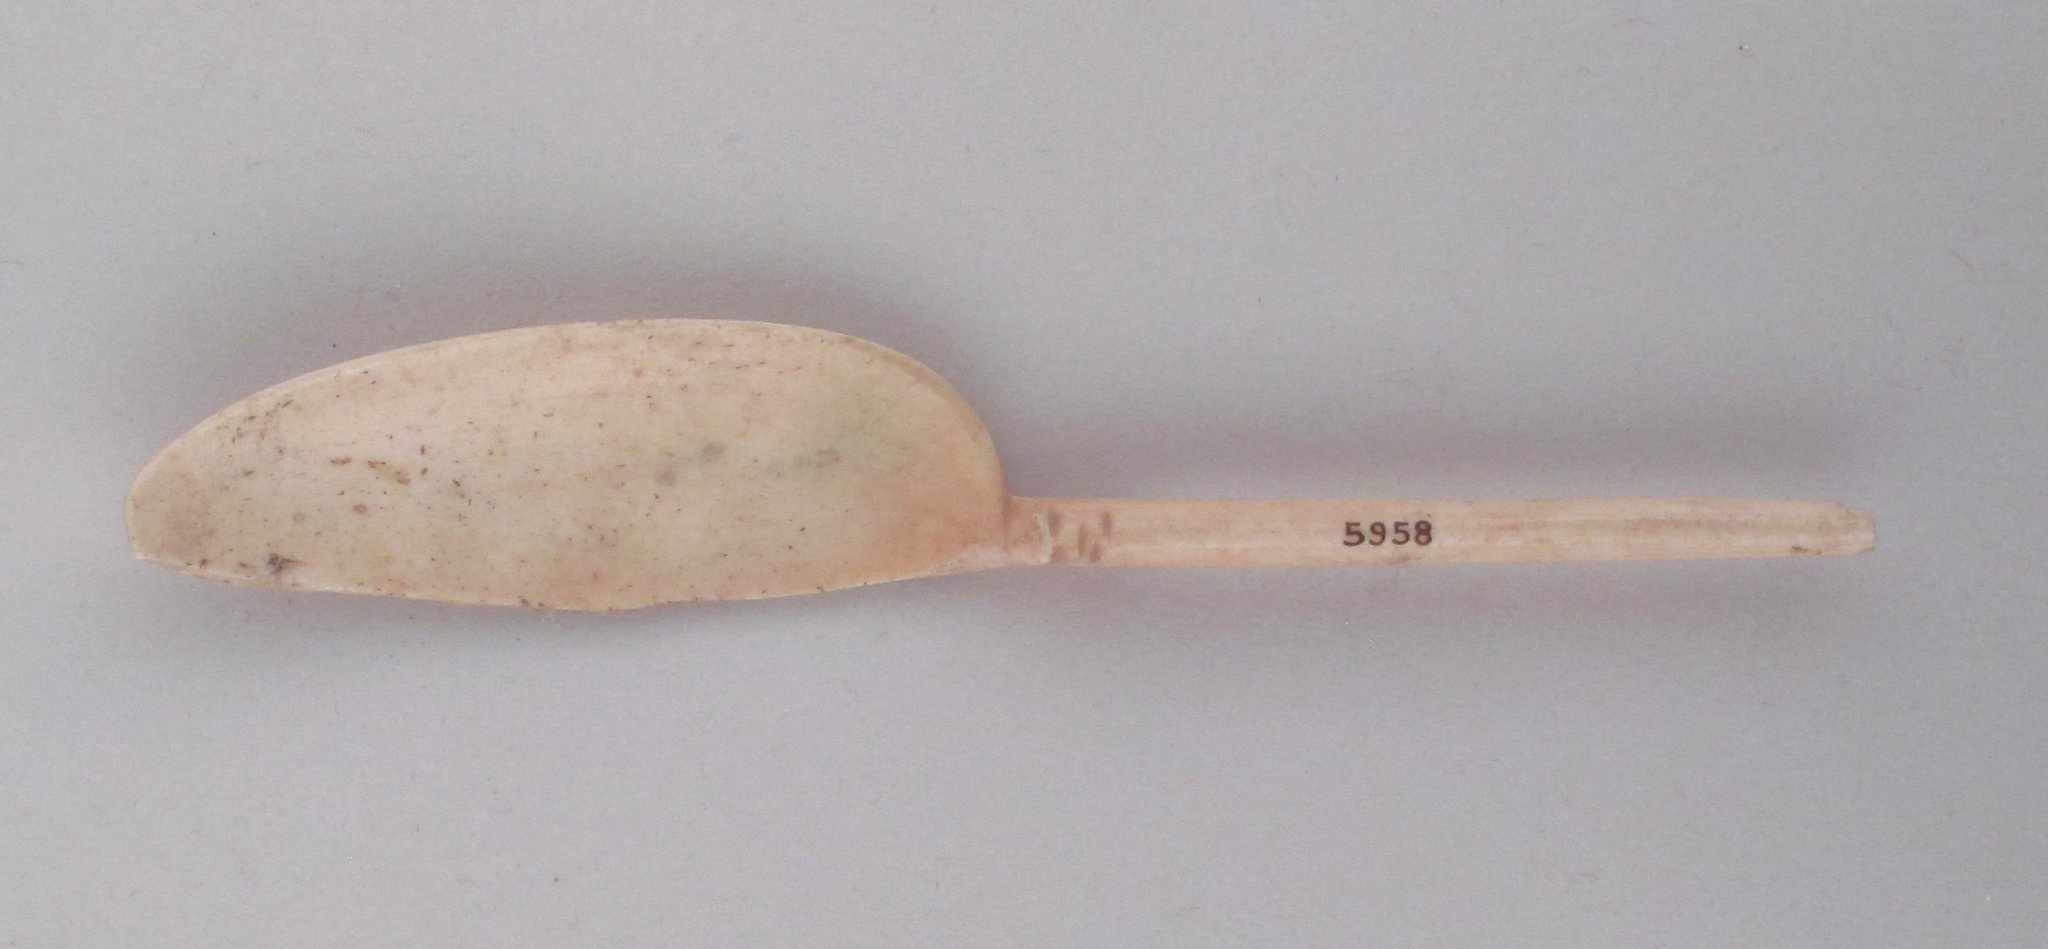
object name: spoon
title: Bone spoon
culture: cypriot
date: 7000 BCE-330 CE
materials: bone